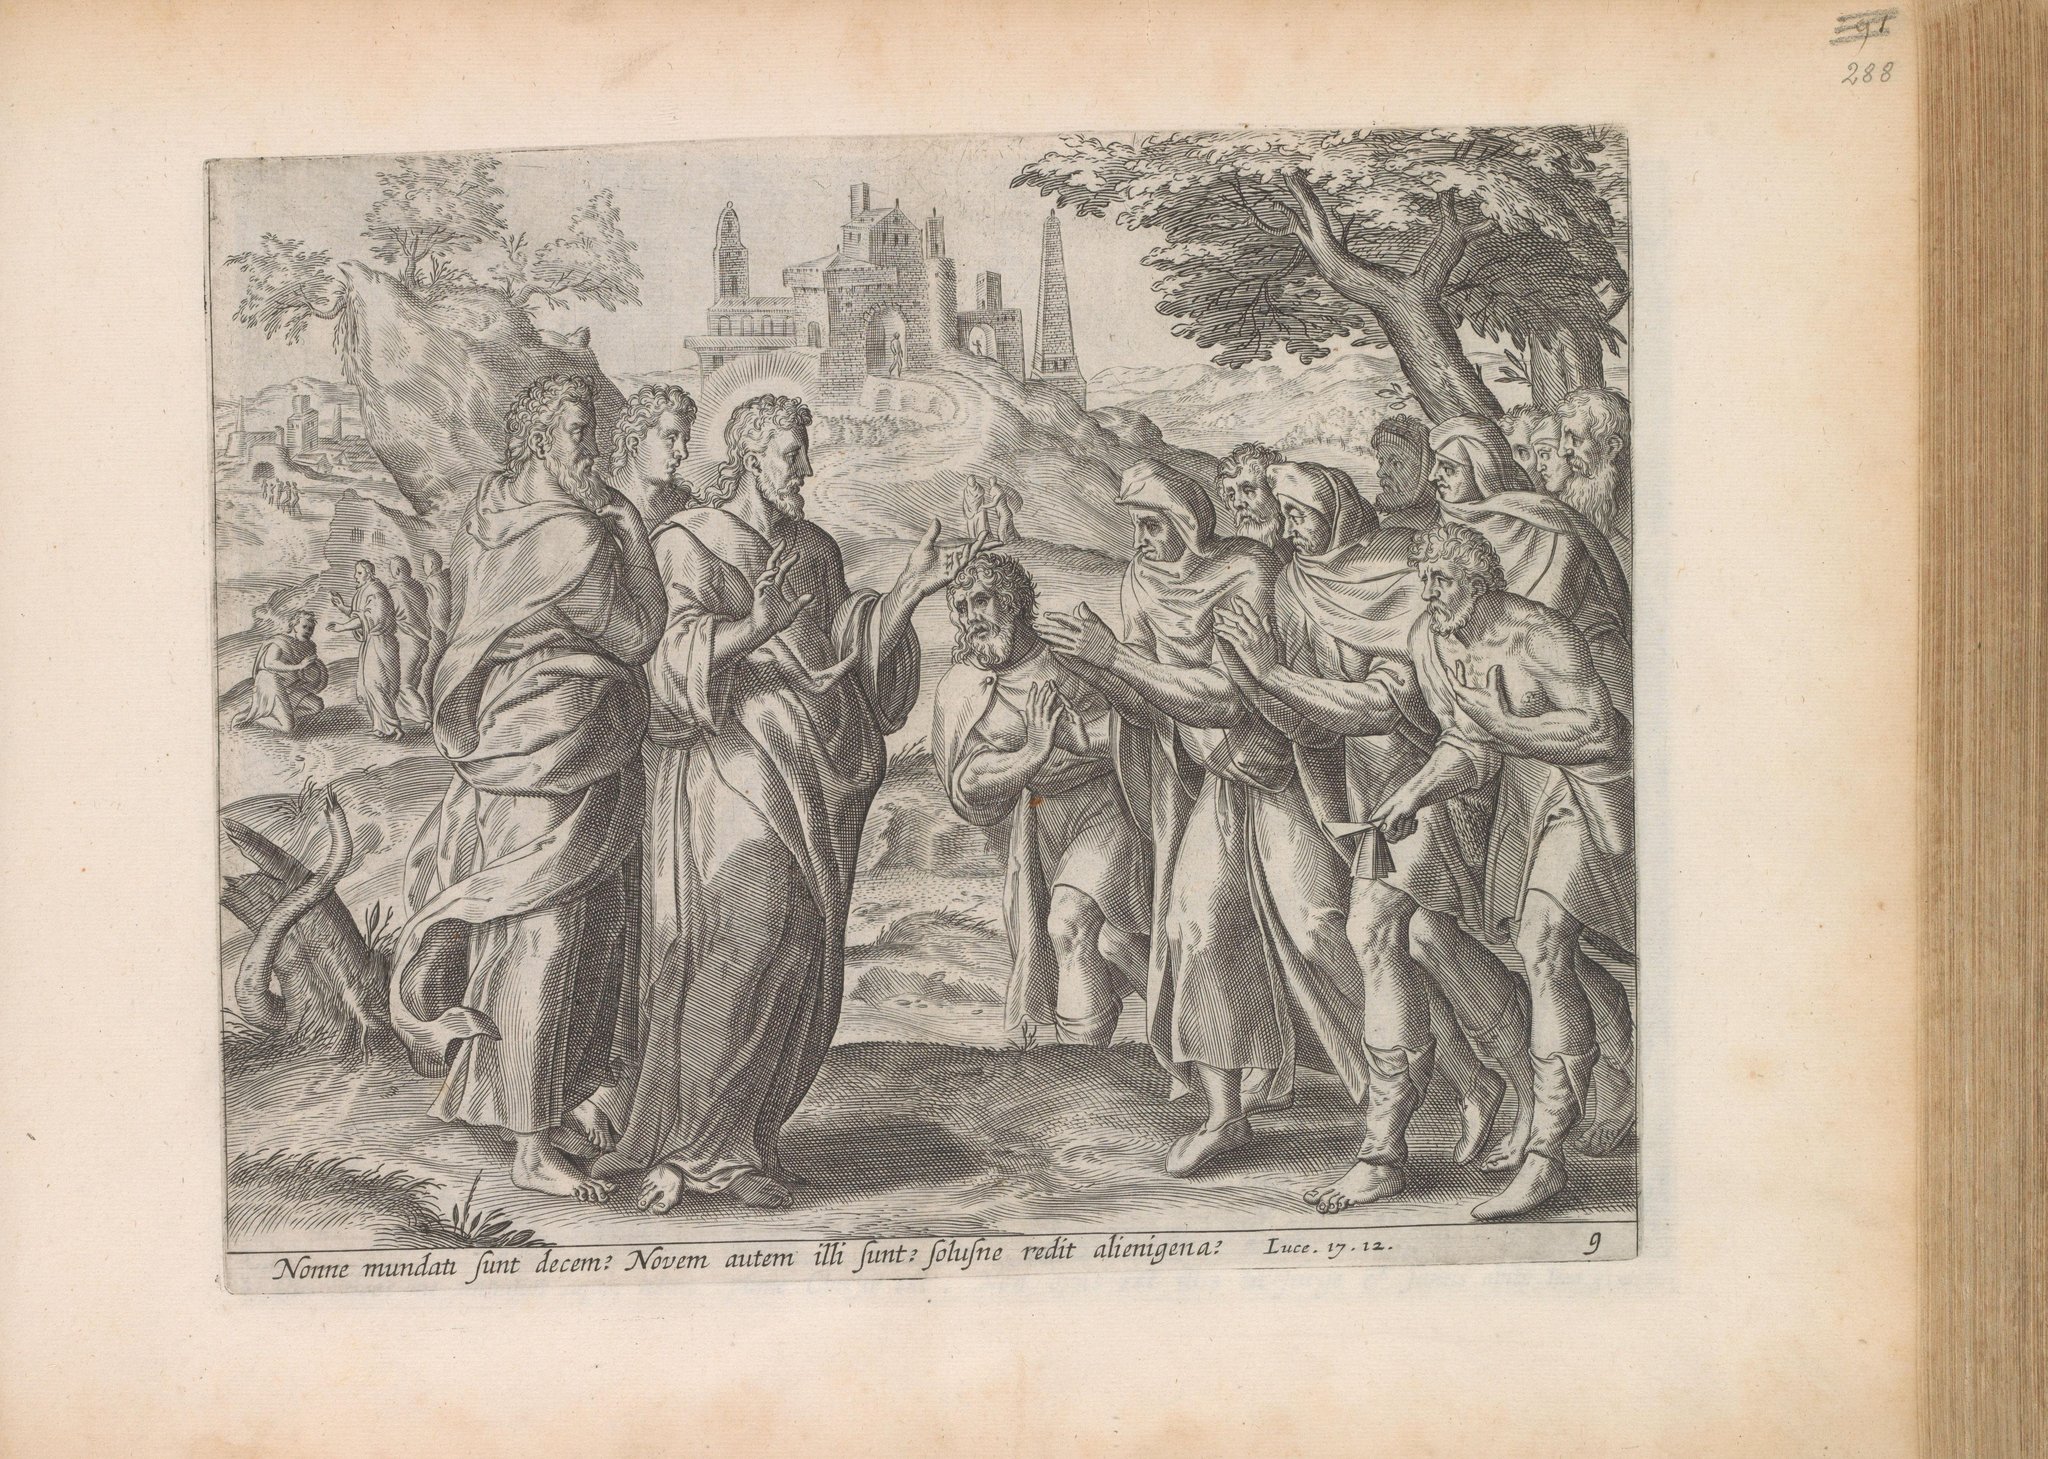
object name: print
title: Theatrum Biblicum Hoc Est Historiae Sacrae Veteris et Novi Testamenti Tabulis Aeneis Expressae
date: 1572-1576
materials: paper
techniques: engraving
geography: amsterdam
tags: one leper, a samaritan, sent to the priest by christ, returns and kneels before him, christ sends ten lepers to the priest (luke 17:11-19)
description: Christus ontmoet tien mensen die aan huidvraat lijden en geeft hen de opdracht om zich aan de priesters te laten zien. Als ze dat doen blijkt dat ze zijn genezen. Slechts een van de tien, een Samaritaan, keert links op de achtergrond terug en knielt voor Christus om hem te bedanken. Onder de voorstelling een verwijzing in het Latijn naar de Bijbeltekst in Luc. 17:12. Deze prent maakt deel uit van een album.